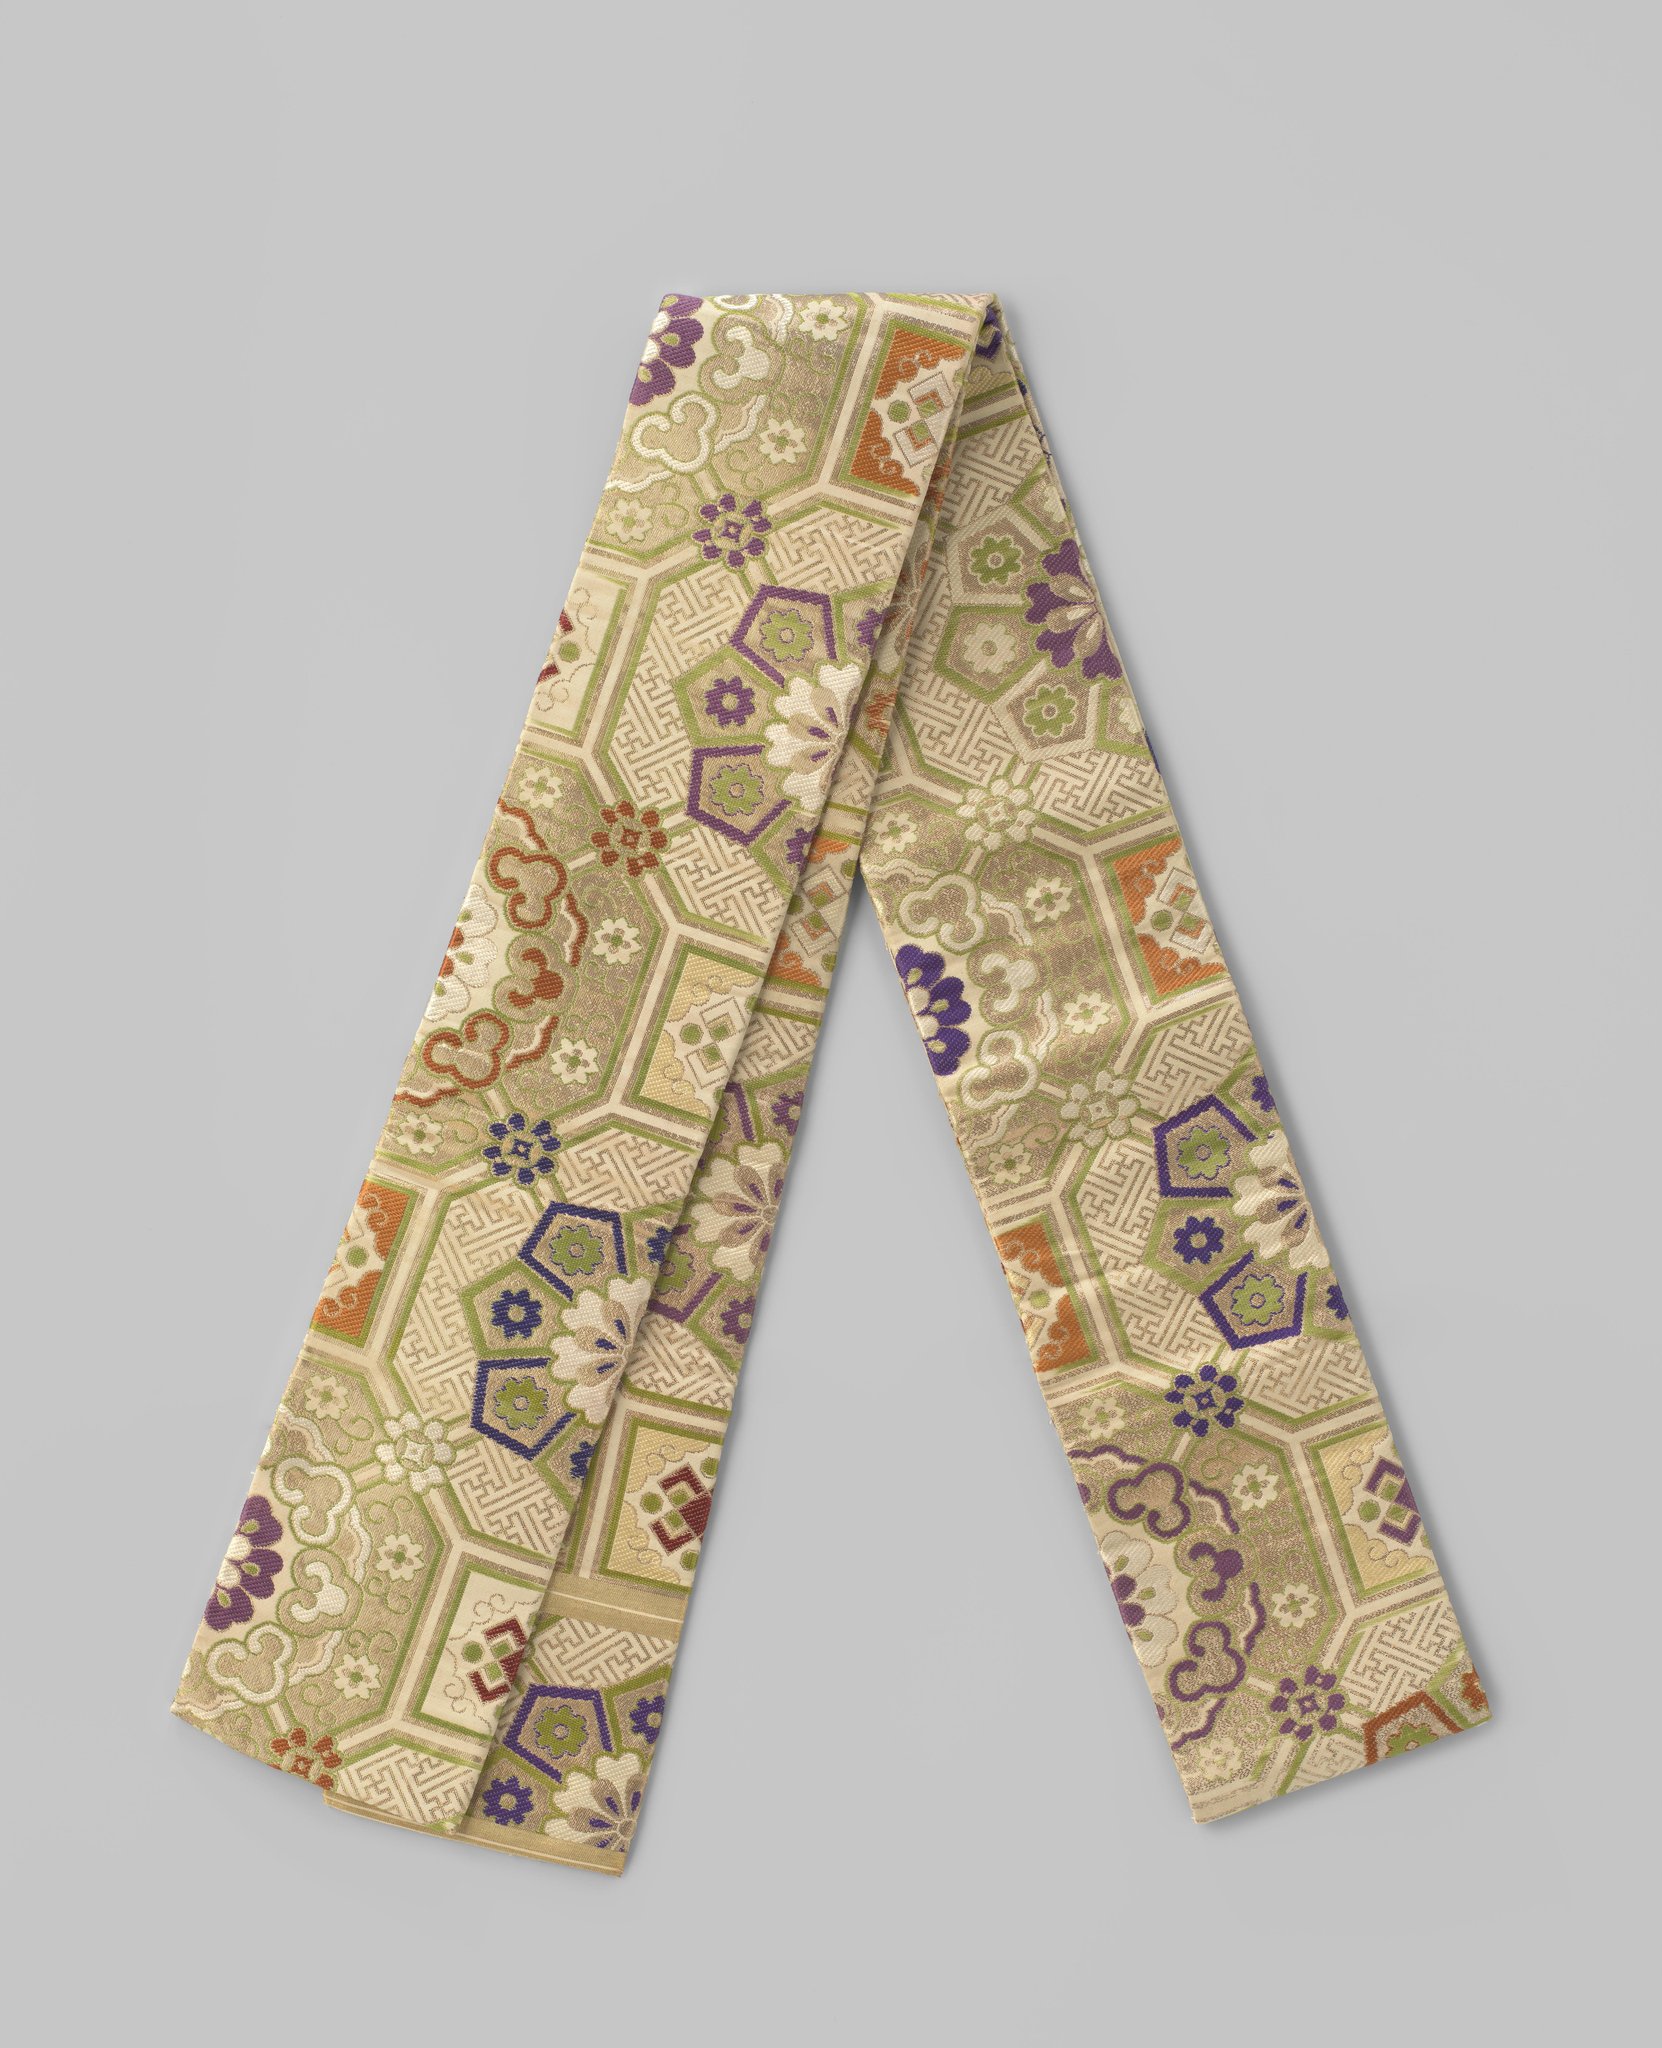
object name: obi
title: Vrouwen hanhaba obi met Chinese bloemen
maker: Anonymous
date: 1920-1940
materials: silk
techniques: weave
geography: japan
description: Ceintuur van zijdebrokaat voor een kimono van een halve breedte (hanhaba obi) voor een vrouw, met een versiering over het hele vlakvan bloemmotieven en geometrische patronen. Ivoorwitte zijde met brokaat geweven decoratie (nishiki).